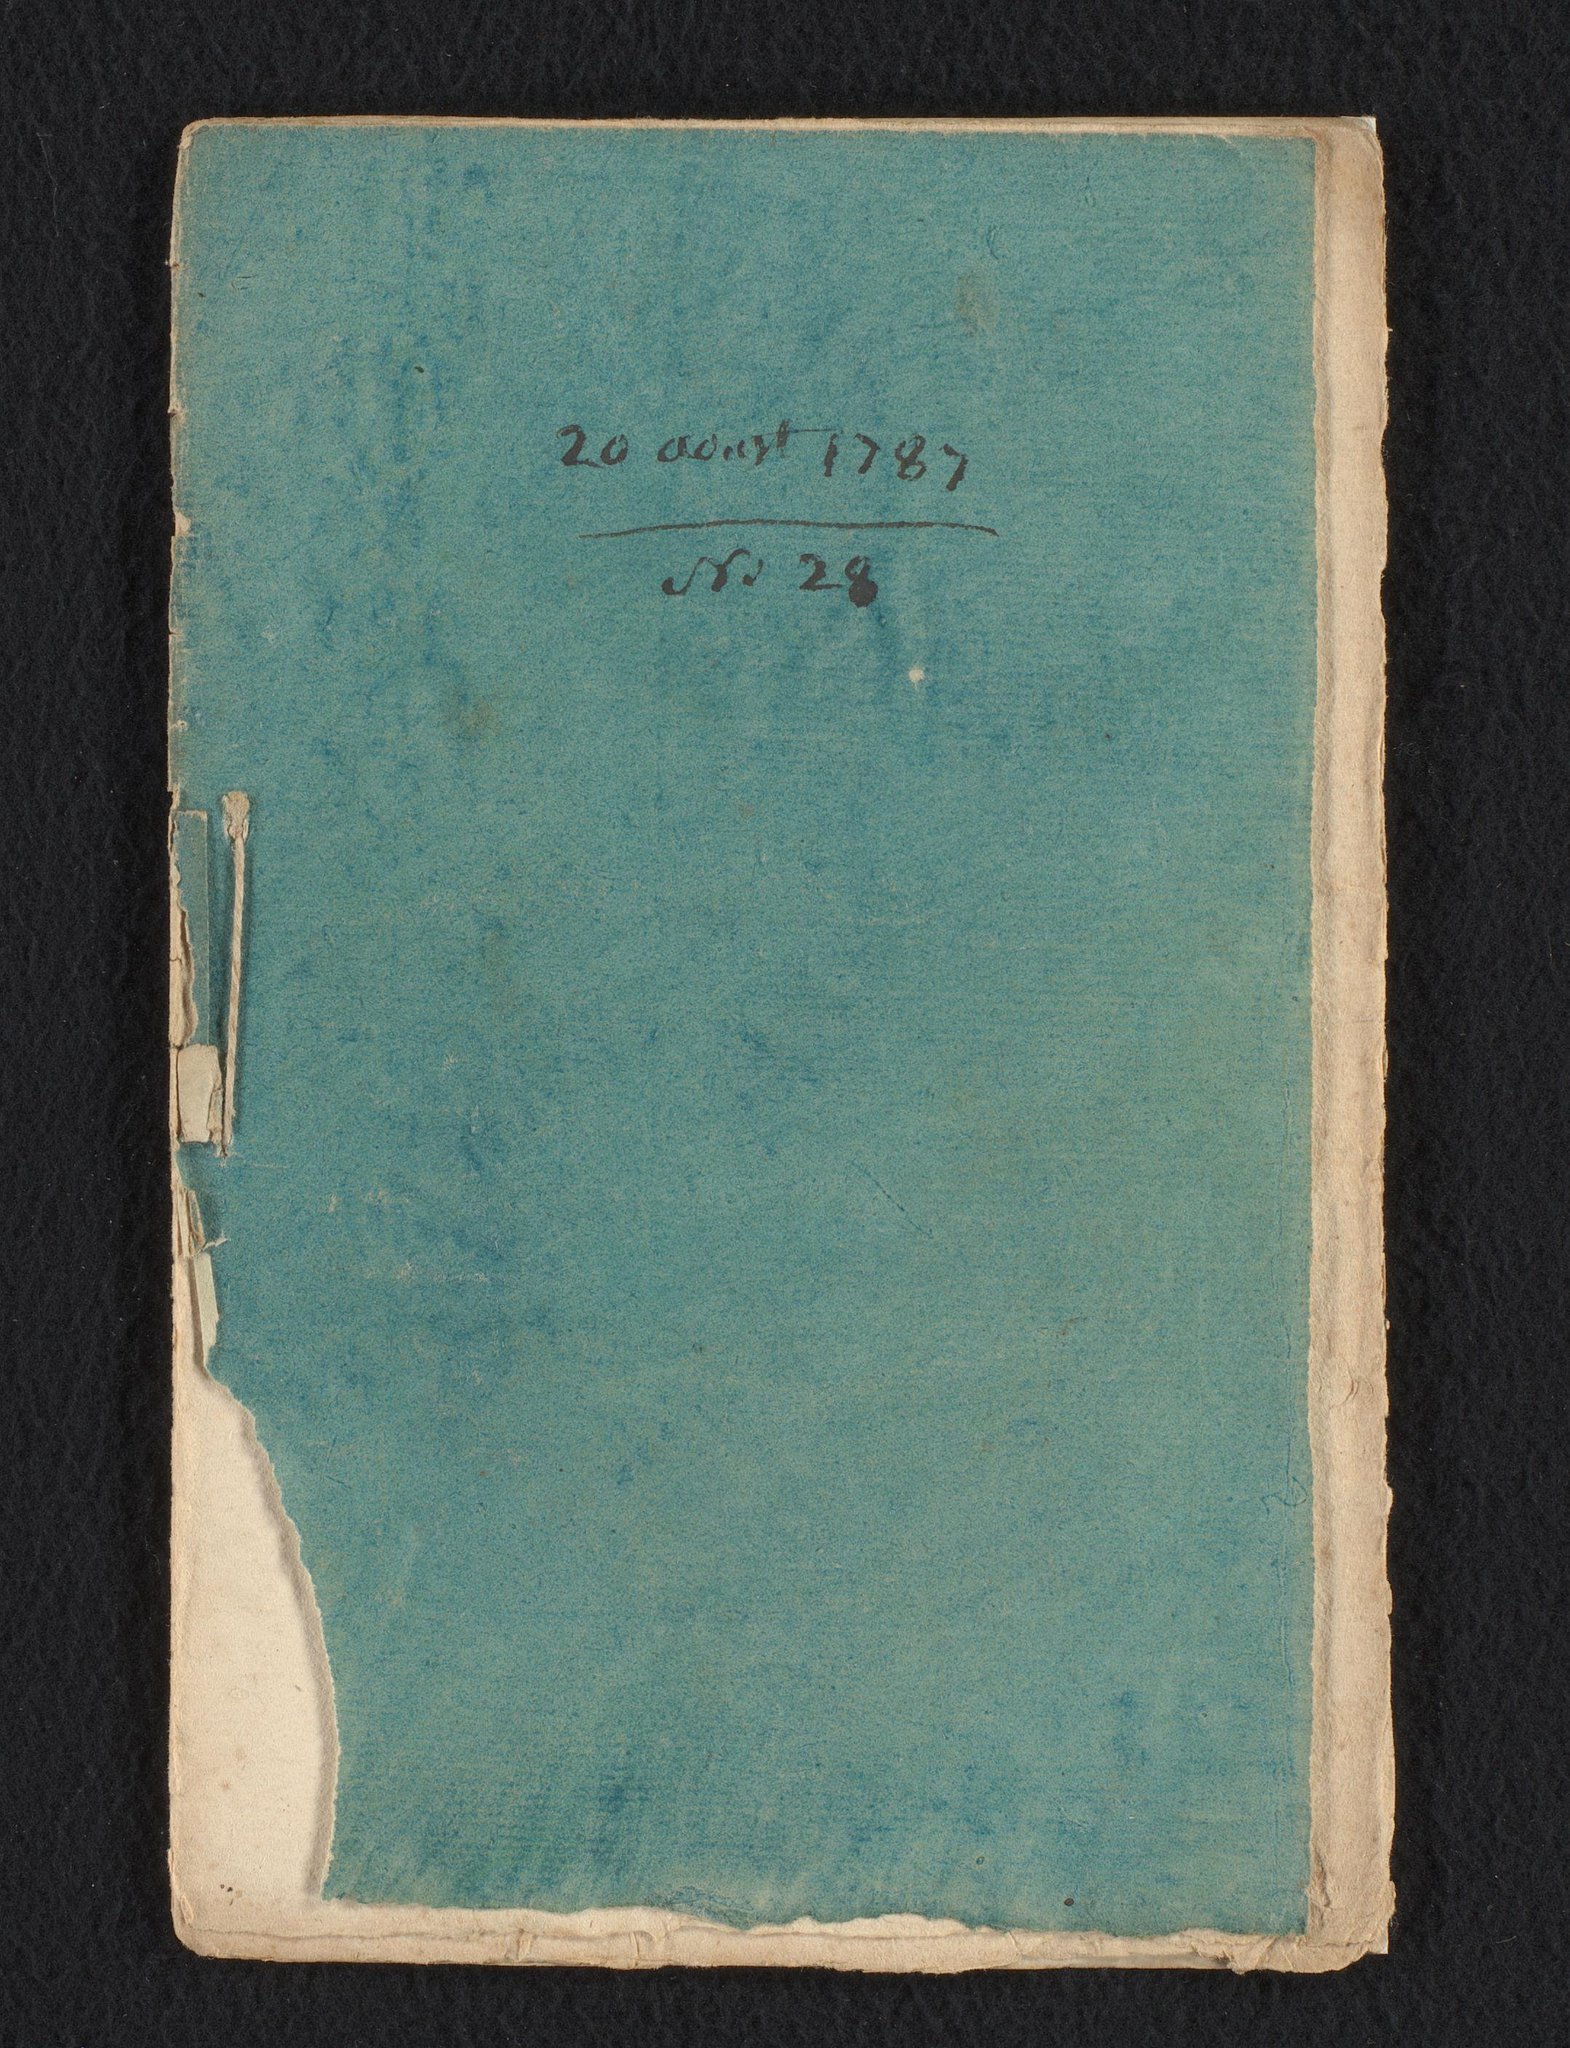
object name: magazine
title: Magasin des Modes Nouvelles Françaises et Anglaises, 20 août 1787, 3e Année, 28e cahier,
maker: buisson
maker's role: publisher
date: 1787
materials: paper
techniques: engraving, hand coloring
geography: paris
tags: fashion plates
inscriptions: date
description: 28e Cahier, 20 août 1787, (Troisième Année), pp. 217-224 + 2 prenten. Cahier uit het modetijdschrift Magasin des Modes Nouvelles Françaises et Anglaises, Parijs, 20 november 1786 - 21 décembre 1789.